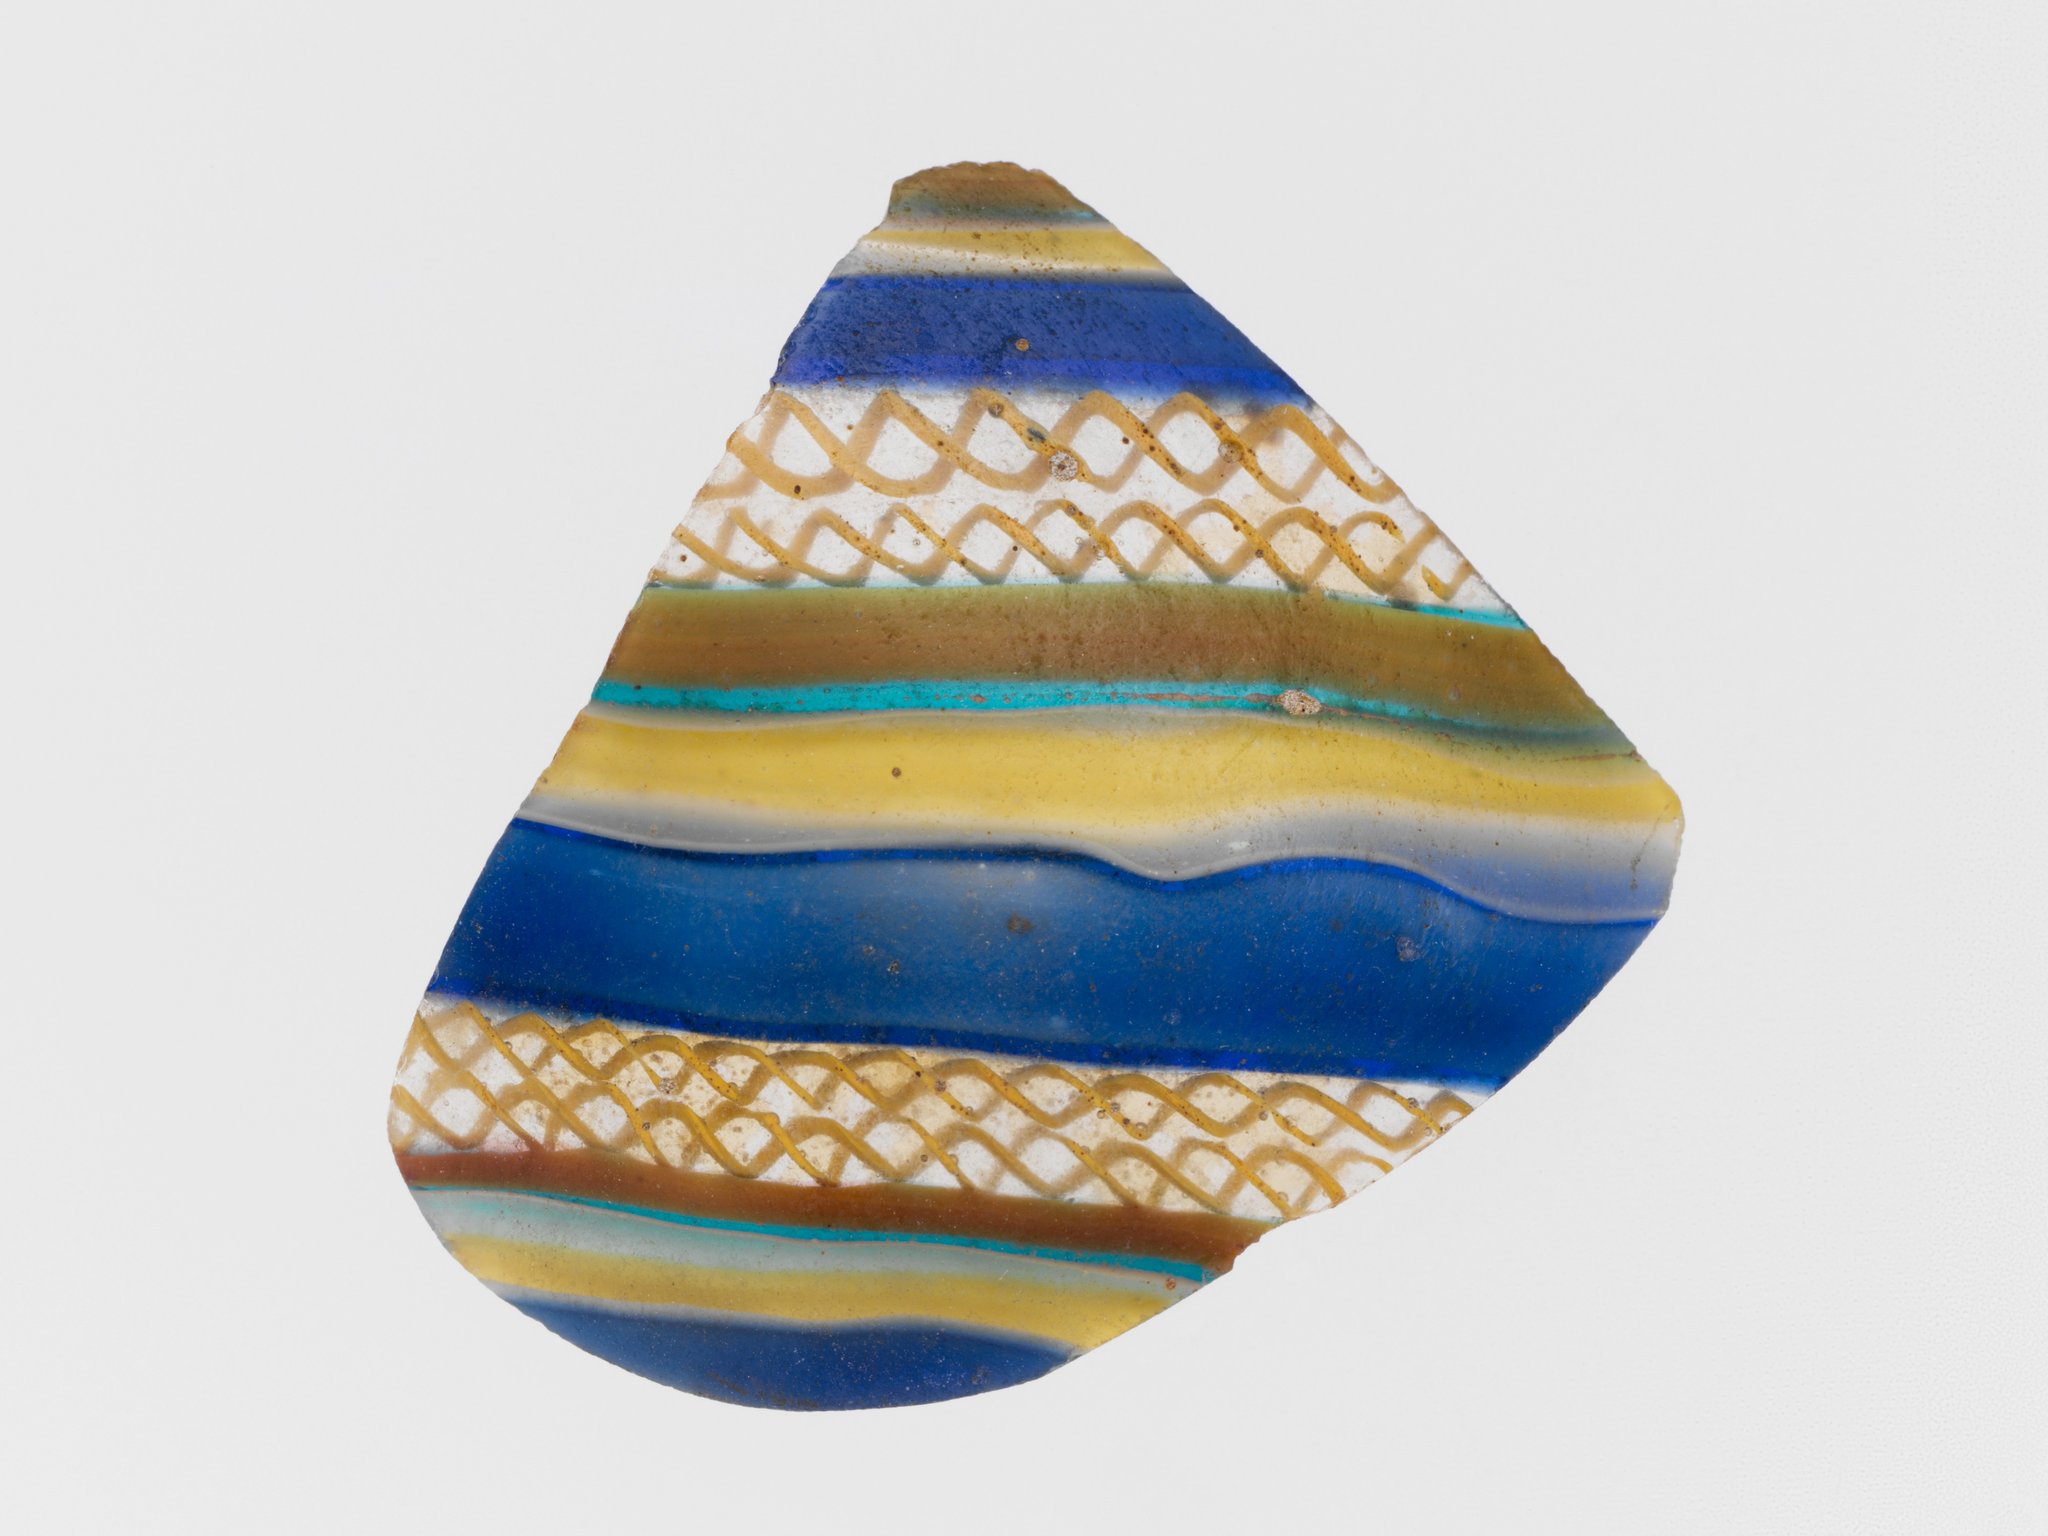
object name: fragment, striped mosaic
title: Glass striped mosaic fragment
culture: roman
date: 34 BCE-33 CE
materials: glass